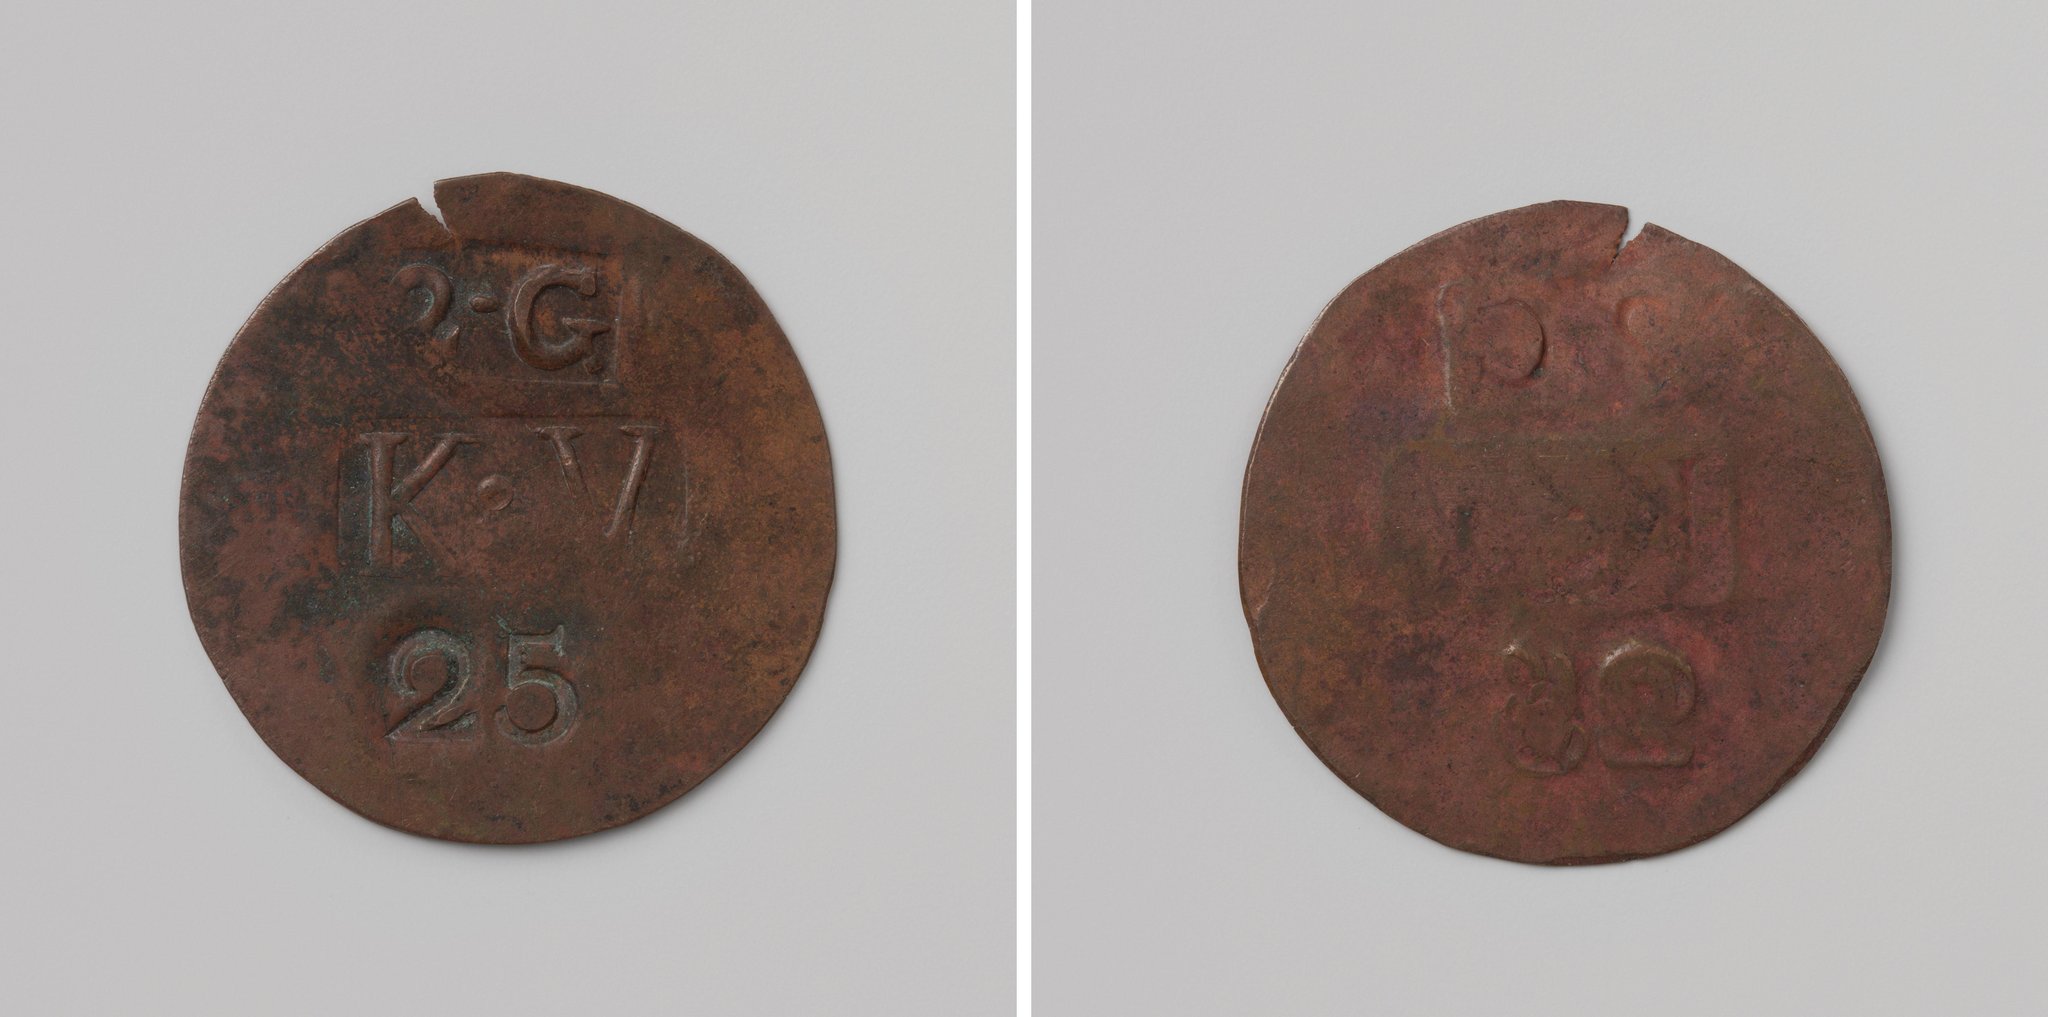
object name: huismunt prison money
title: Tweede gesticht van de kolonie Veenhuizen, huismunt geslagen op last van de Maatschappij van Weldadigheid ter waarde van 25 cent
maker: Anonymous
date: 1818-1859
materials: copper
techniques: striking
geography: netherlands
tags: maatschappij van weldadigheid, veenhuizen